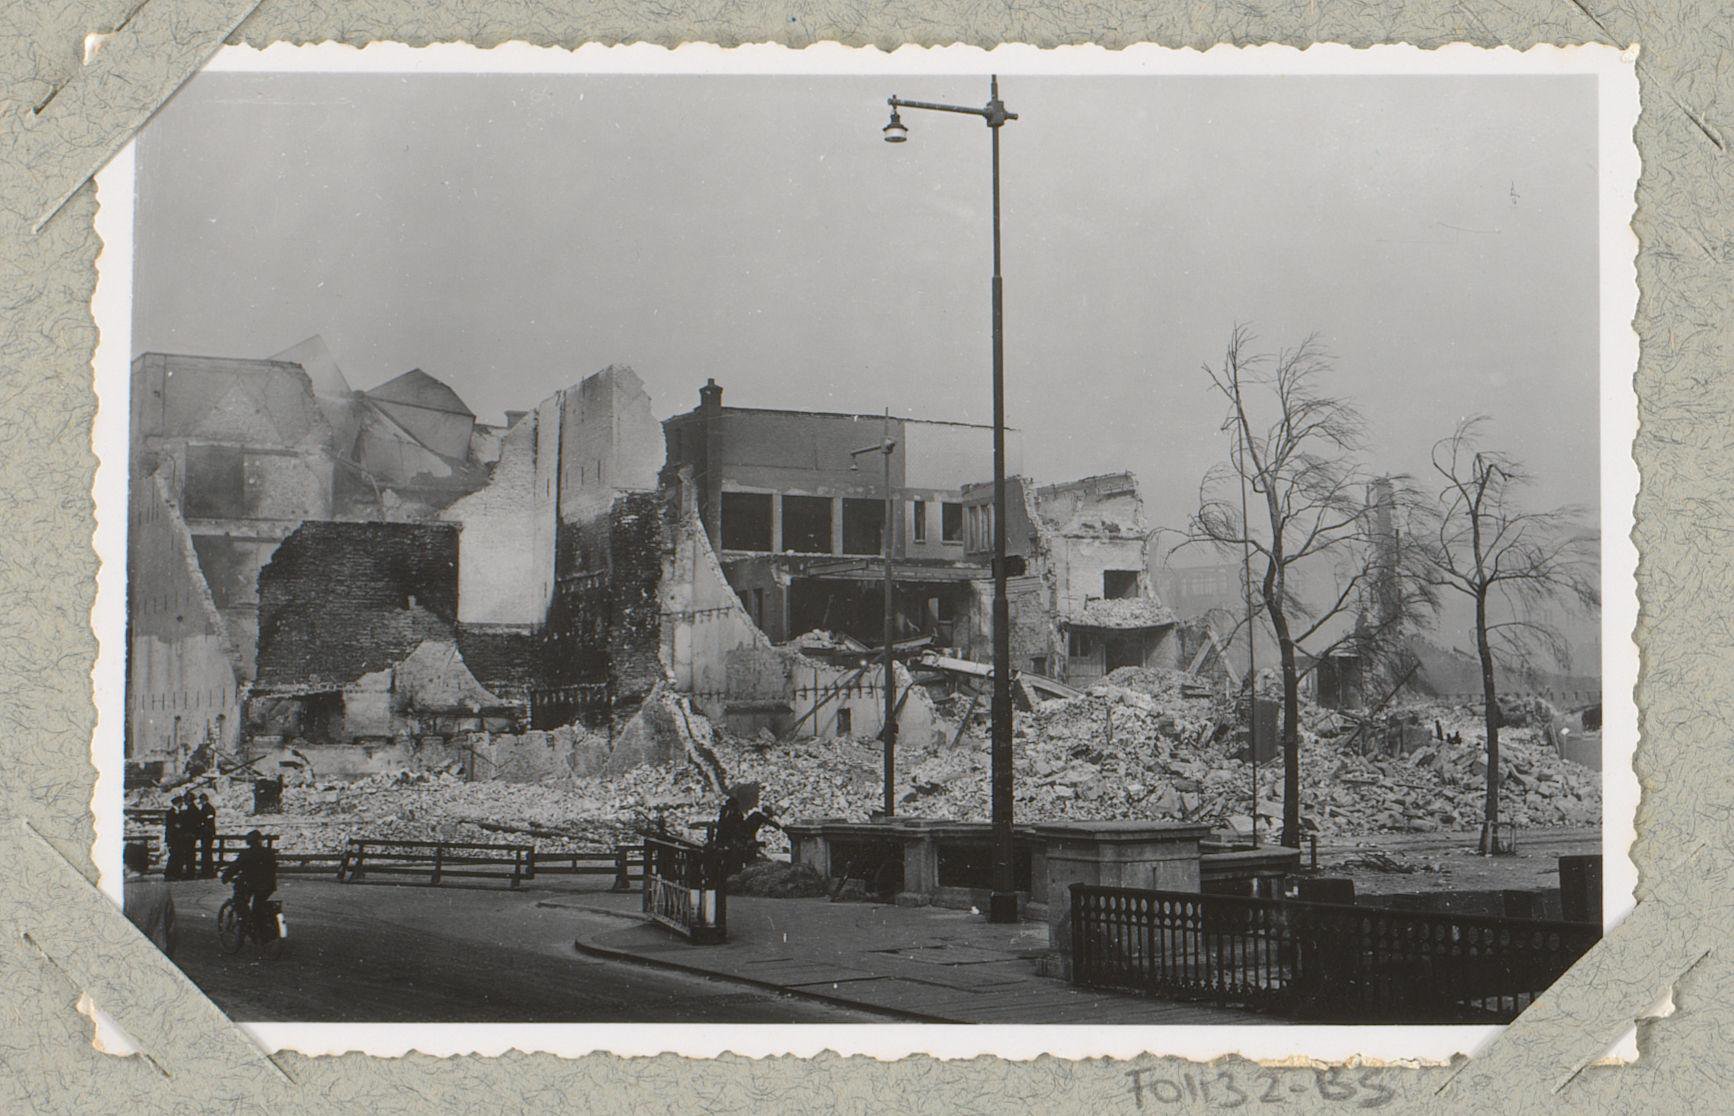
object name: photograph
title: Ruïnes bij de Leuvehaven hoek Eenhoornstraat te Rotterdam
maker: j. nolte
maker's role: fotograaf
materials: photographic support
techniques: gelatin silver print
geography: rotterdam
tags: devastated, ruined place or city (~ warfare), ruin of a dwelling, house, castle, etc., rotterdam, rotterdam blitz